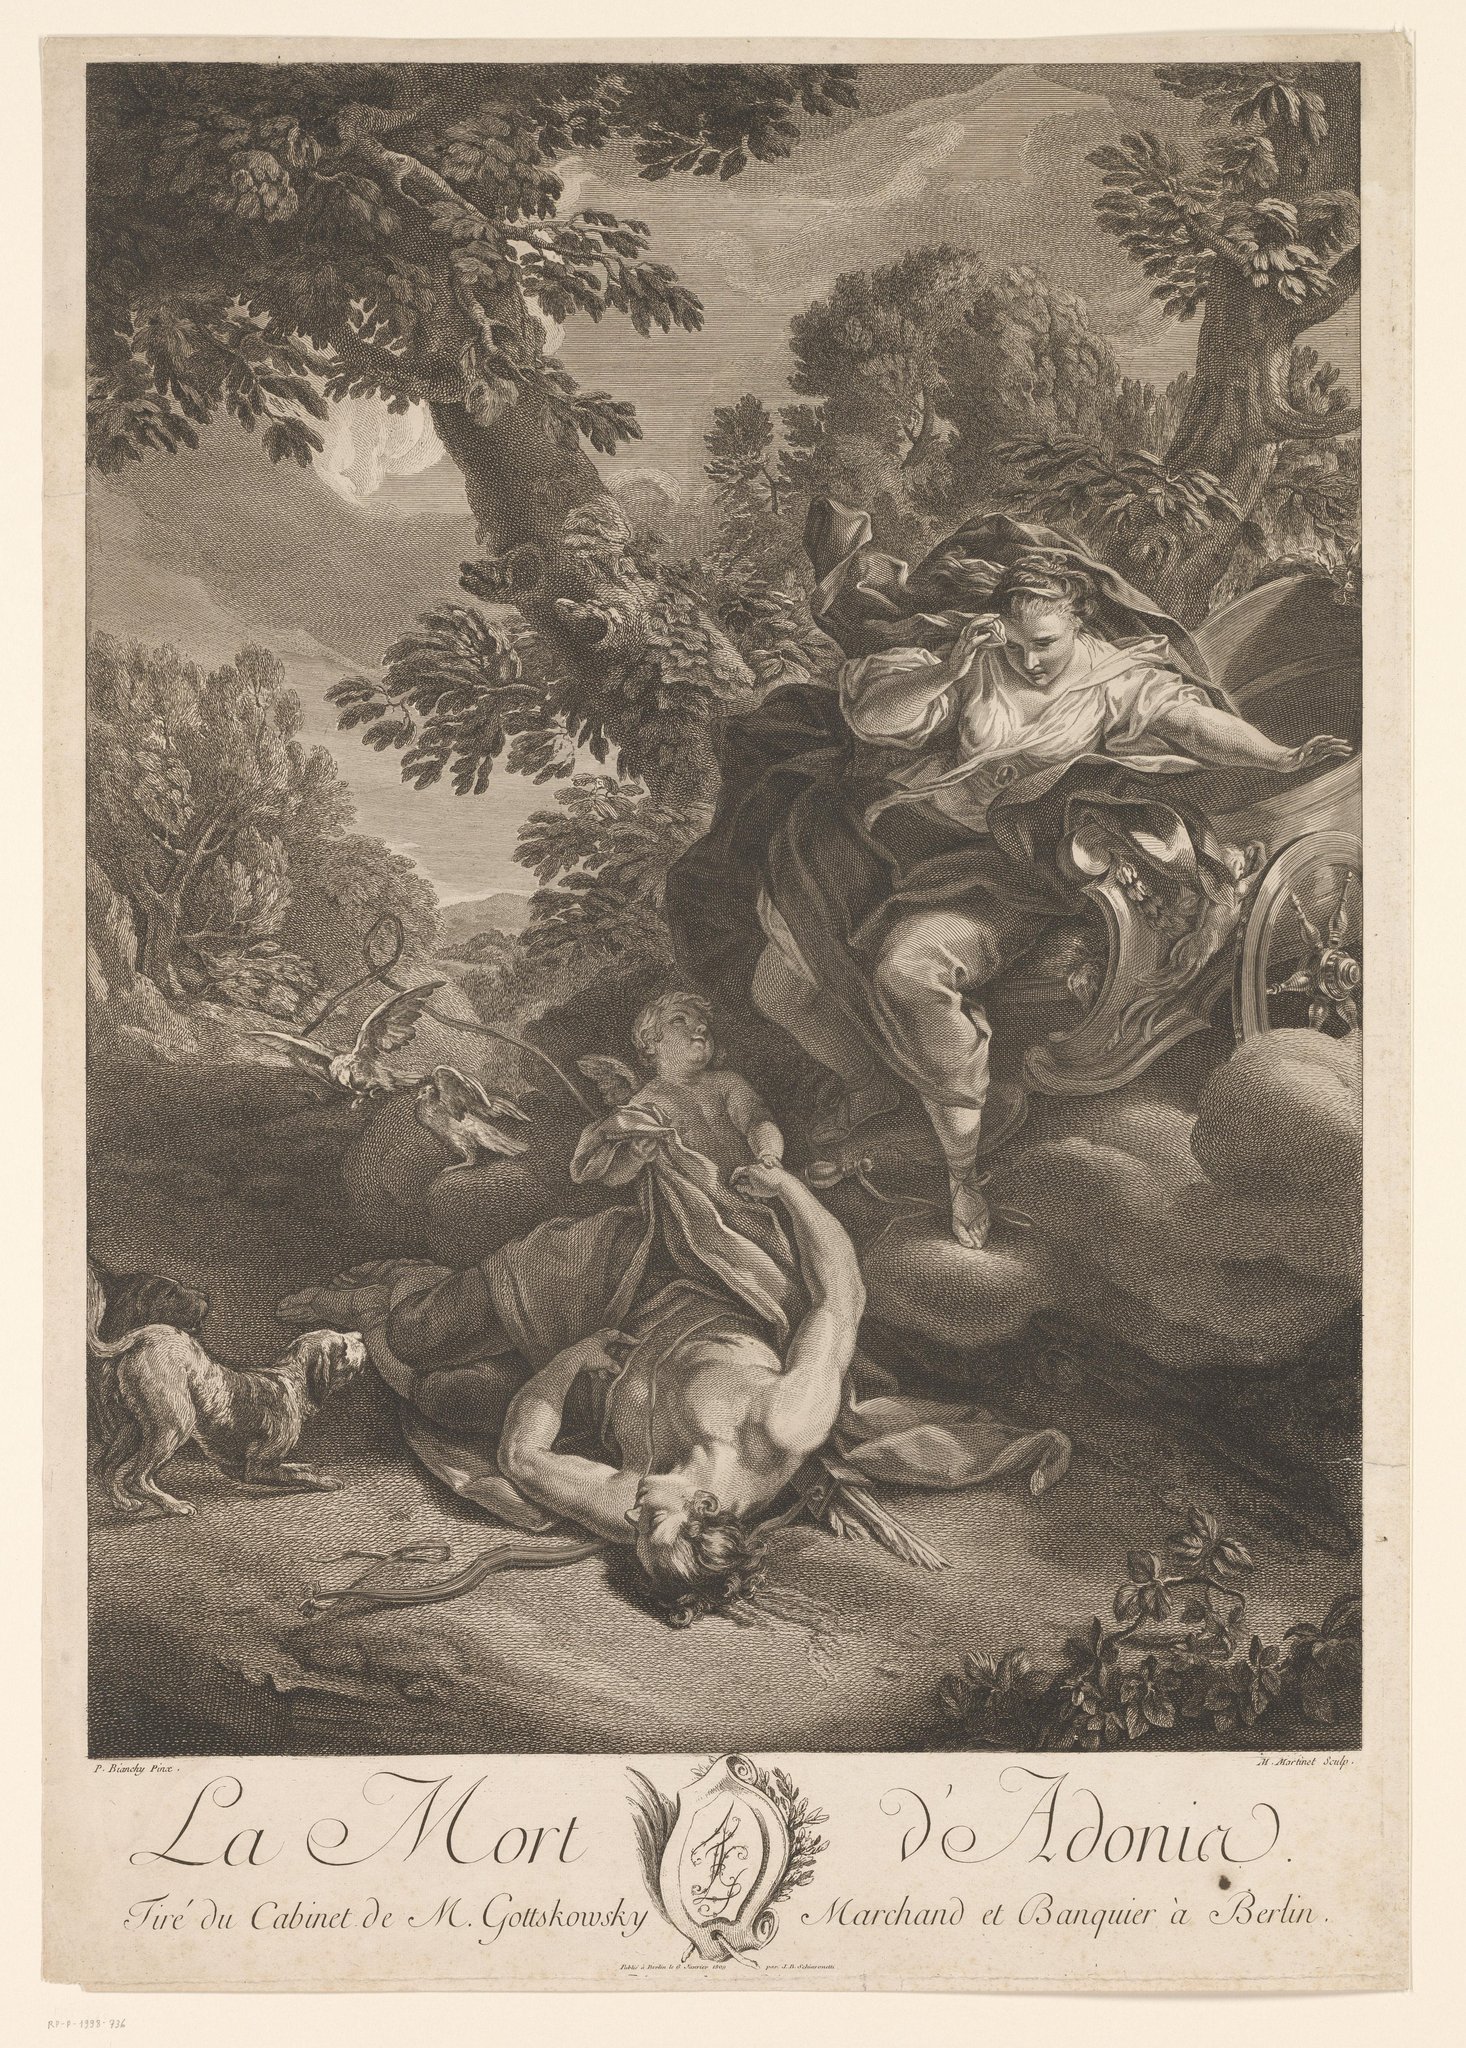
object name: print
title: La Mort d'Adonis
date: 1809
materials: paper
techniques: engraving, etching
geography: berlin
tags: death of adonis: he is killed by a boar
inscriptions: date